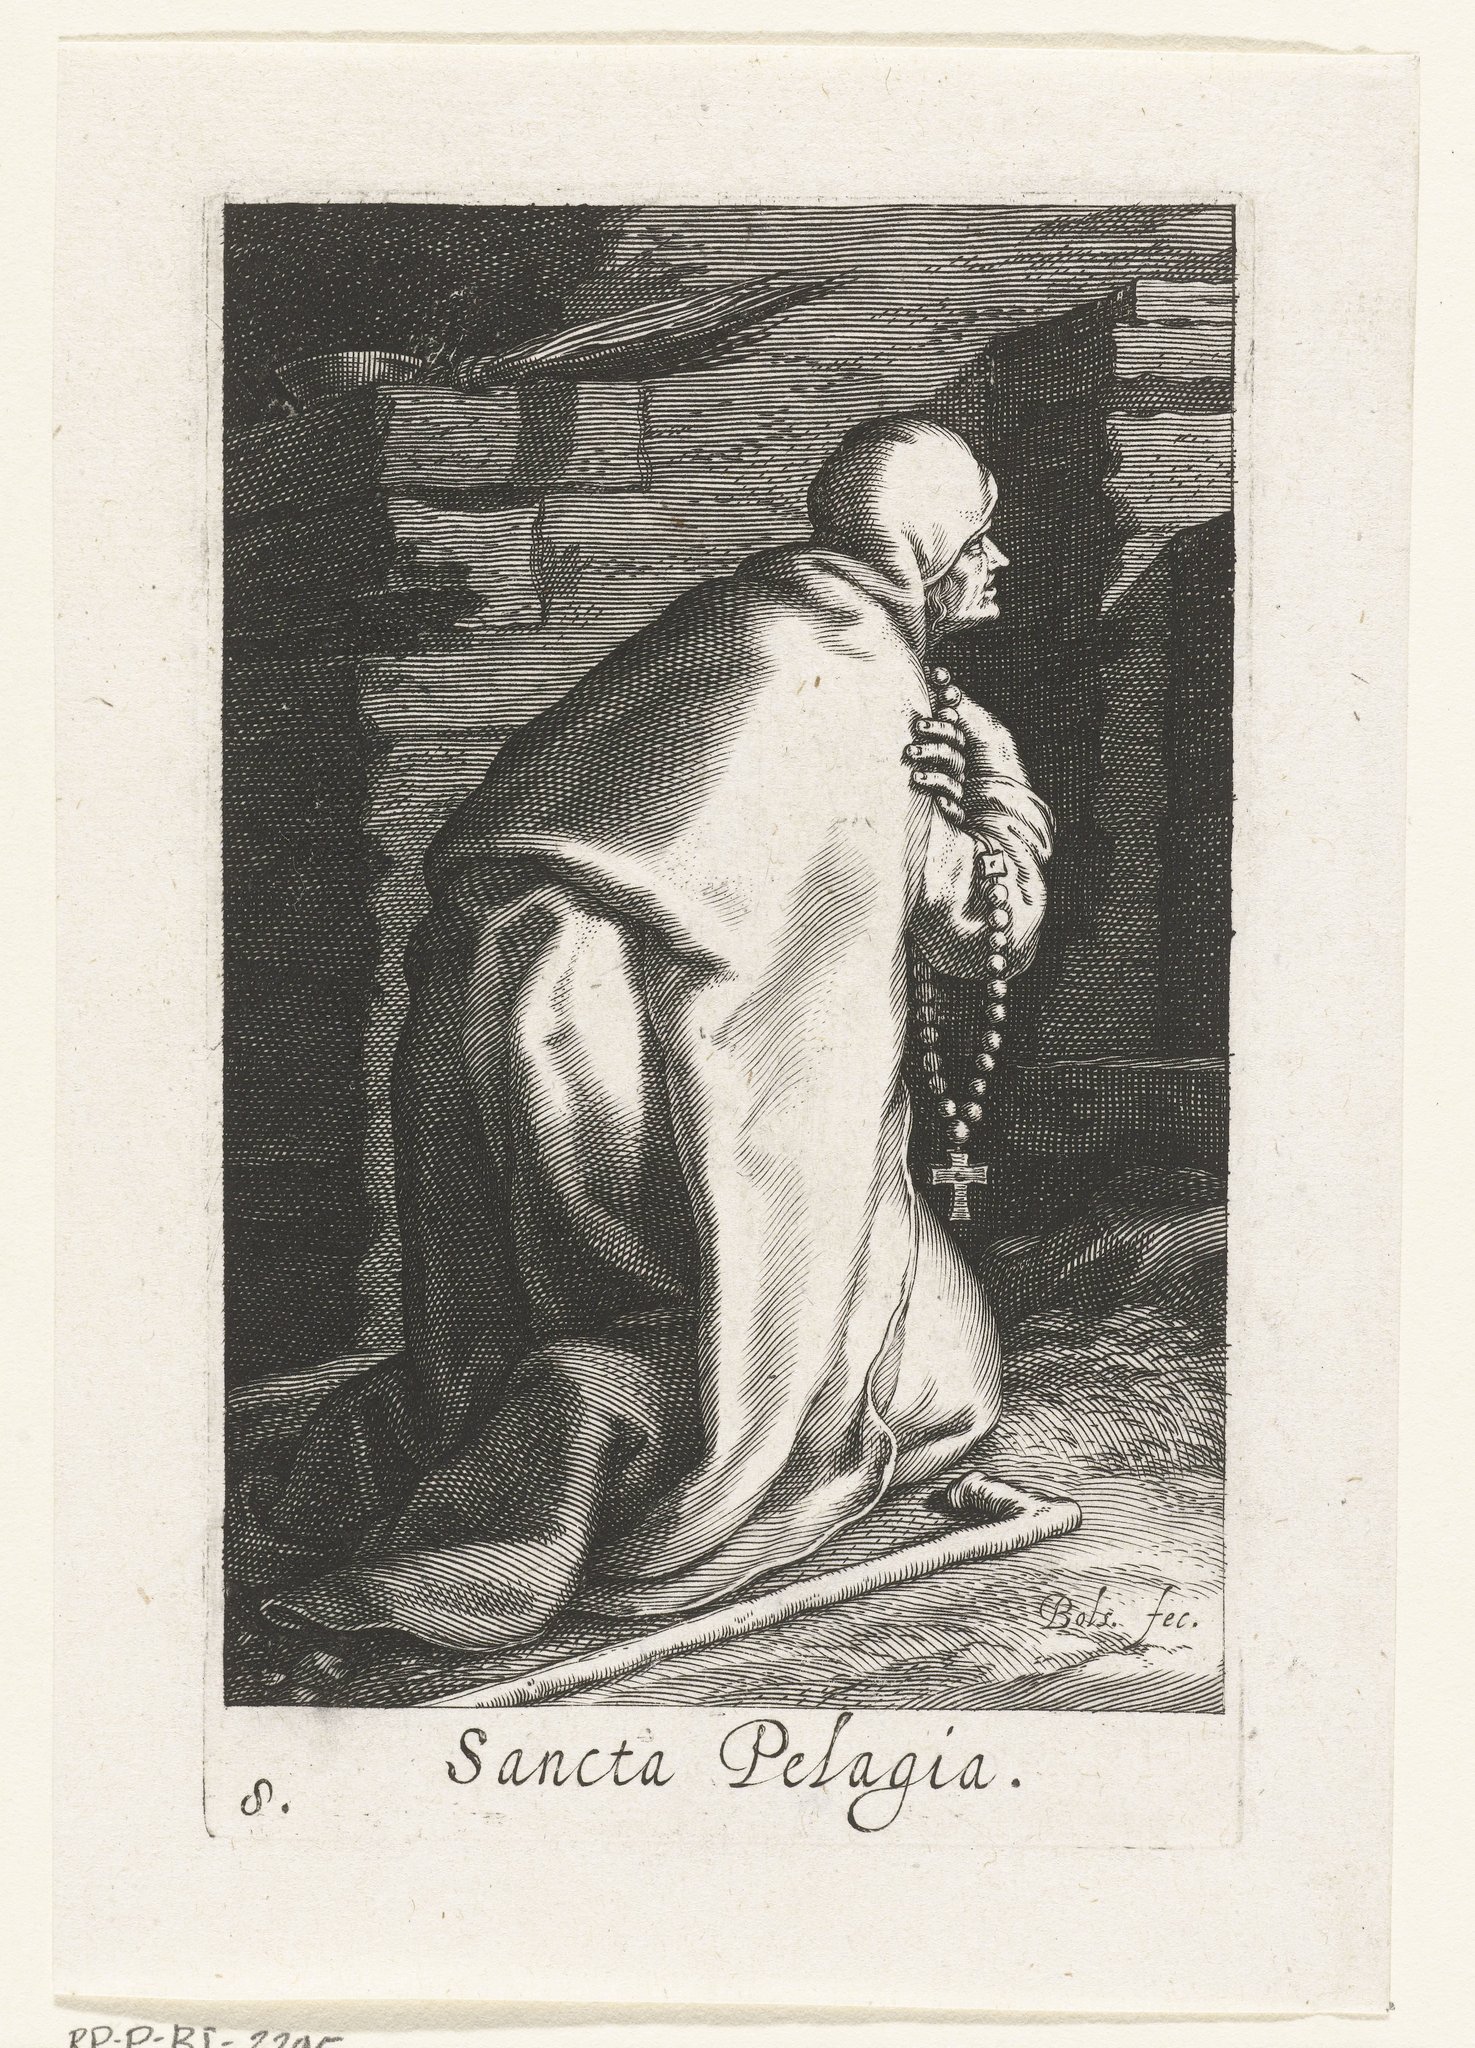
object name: book illustration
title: Heilige Pelagia van Antiochië als kluizenares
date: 1590-1612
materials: paper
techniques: engraving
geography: amsterdam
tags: anchorite, hermit, female saints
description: Prent uit: Sacra Eremus Ascetriarum, uitgever Boëtius Adamsz. Bolswert, 1612 of Hendrik Aertssen, Antwerpen 1619. Prent uit de serie van vijfentwintig kluizenaressen in deze uitgaven. In 1612 verscheen een ongebonden editie maar op basis van de gewijzigde opschriften en samenstelling van de serie kluizenaars wordt aangenomen dat de prenten van de uitgave 1619 ook in 1612 of iets daarvoor gedrukt werden. De serie kluizenaressen bleef vrijwel ongewijzigd in de ongebonden uitgave van 1612, dit compliceert de datering van de losse bladen in de collectie van het RMA, zie Roethlisberger 1993, p. 171-175.